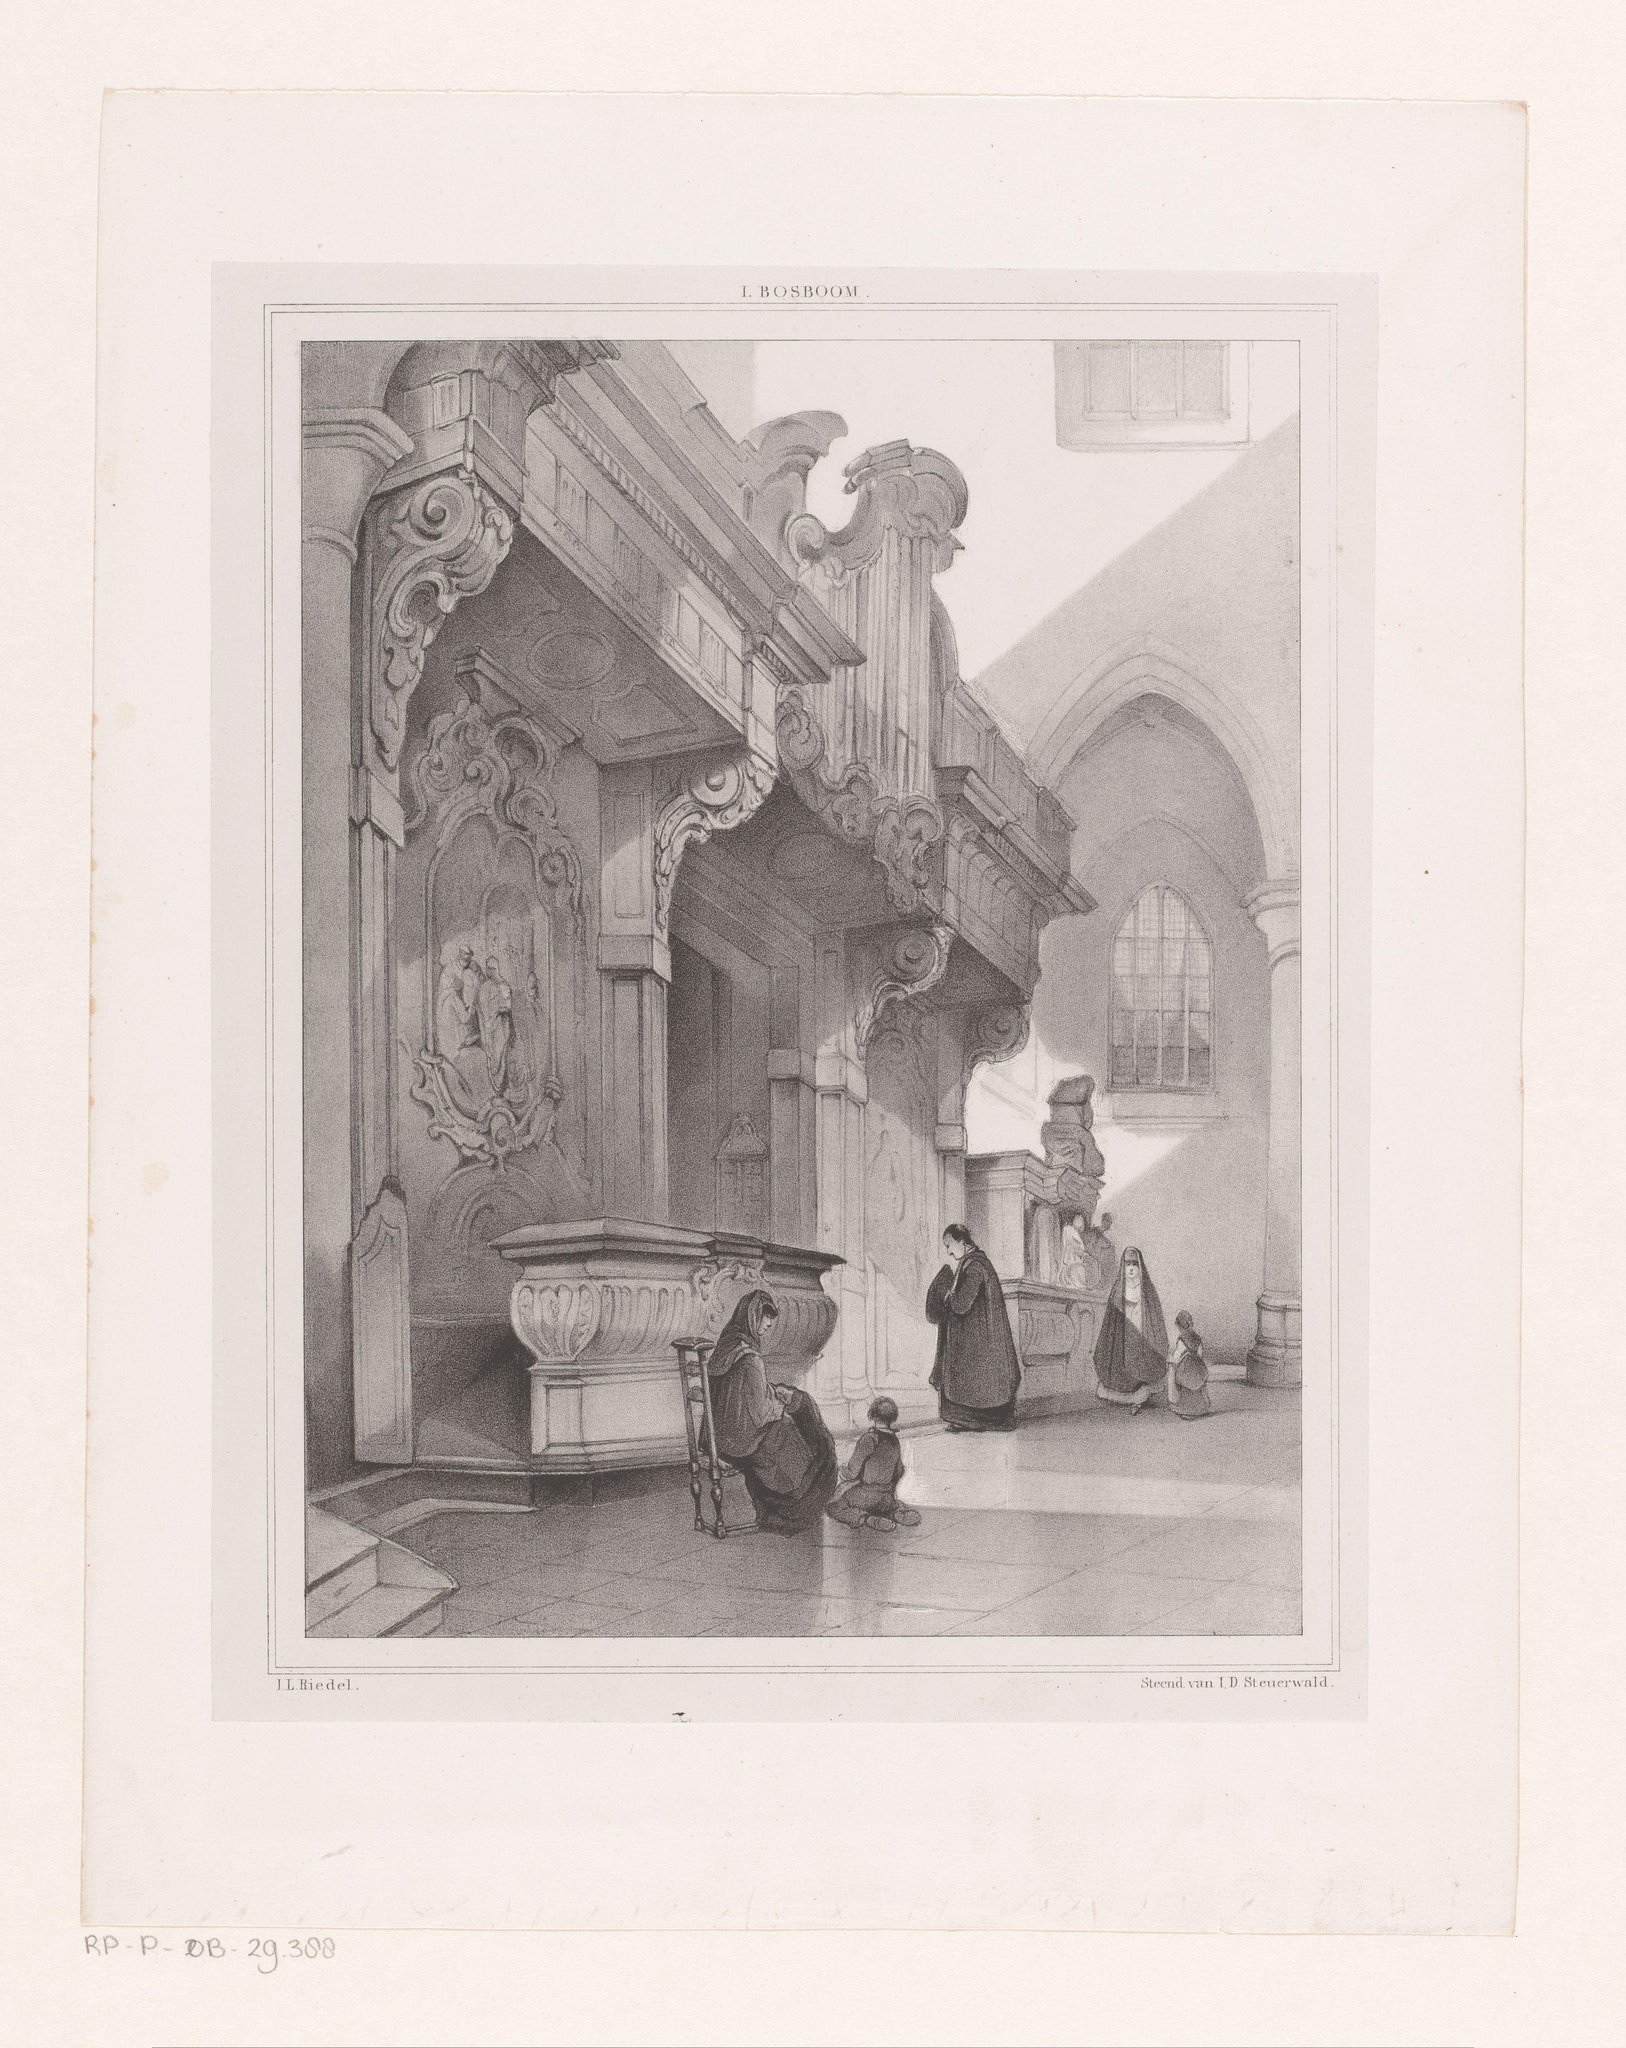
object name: print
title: Kerkinterieur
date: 1844-1845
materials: paper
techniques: lithograph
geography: the hague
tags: interior of church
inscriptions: collector's mark: Lugt 2228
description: Een zittende vrouw, een man, een zuster en twee kinderen in een kerk.